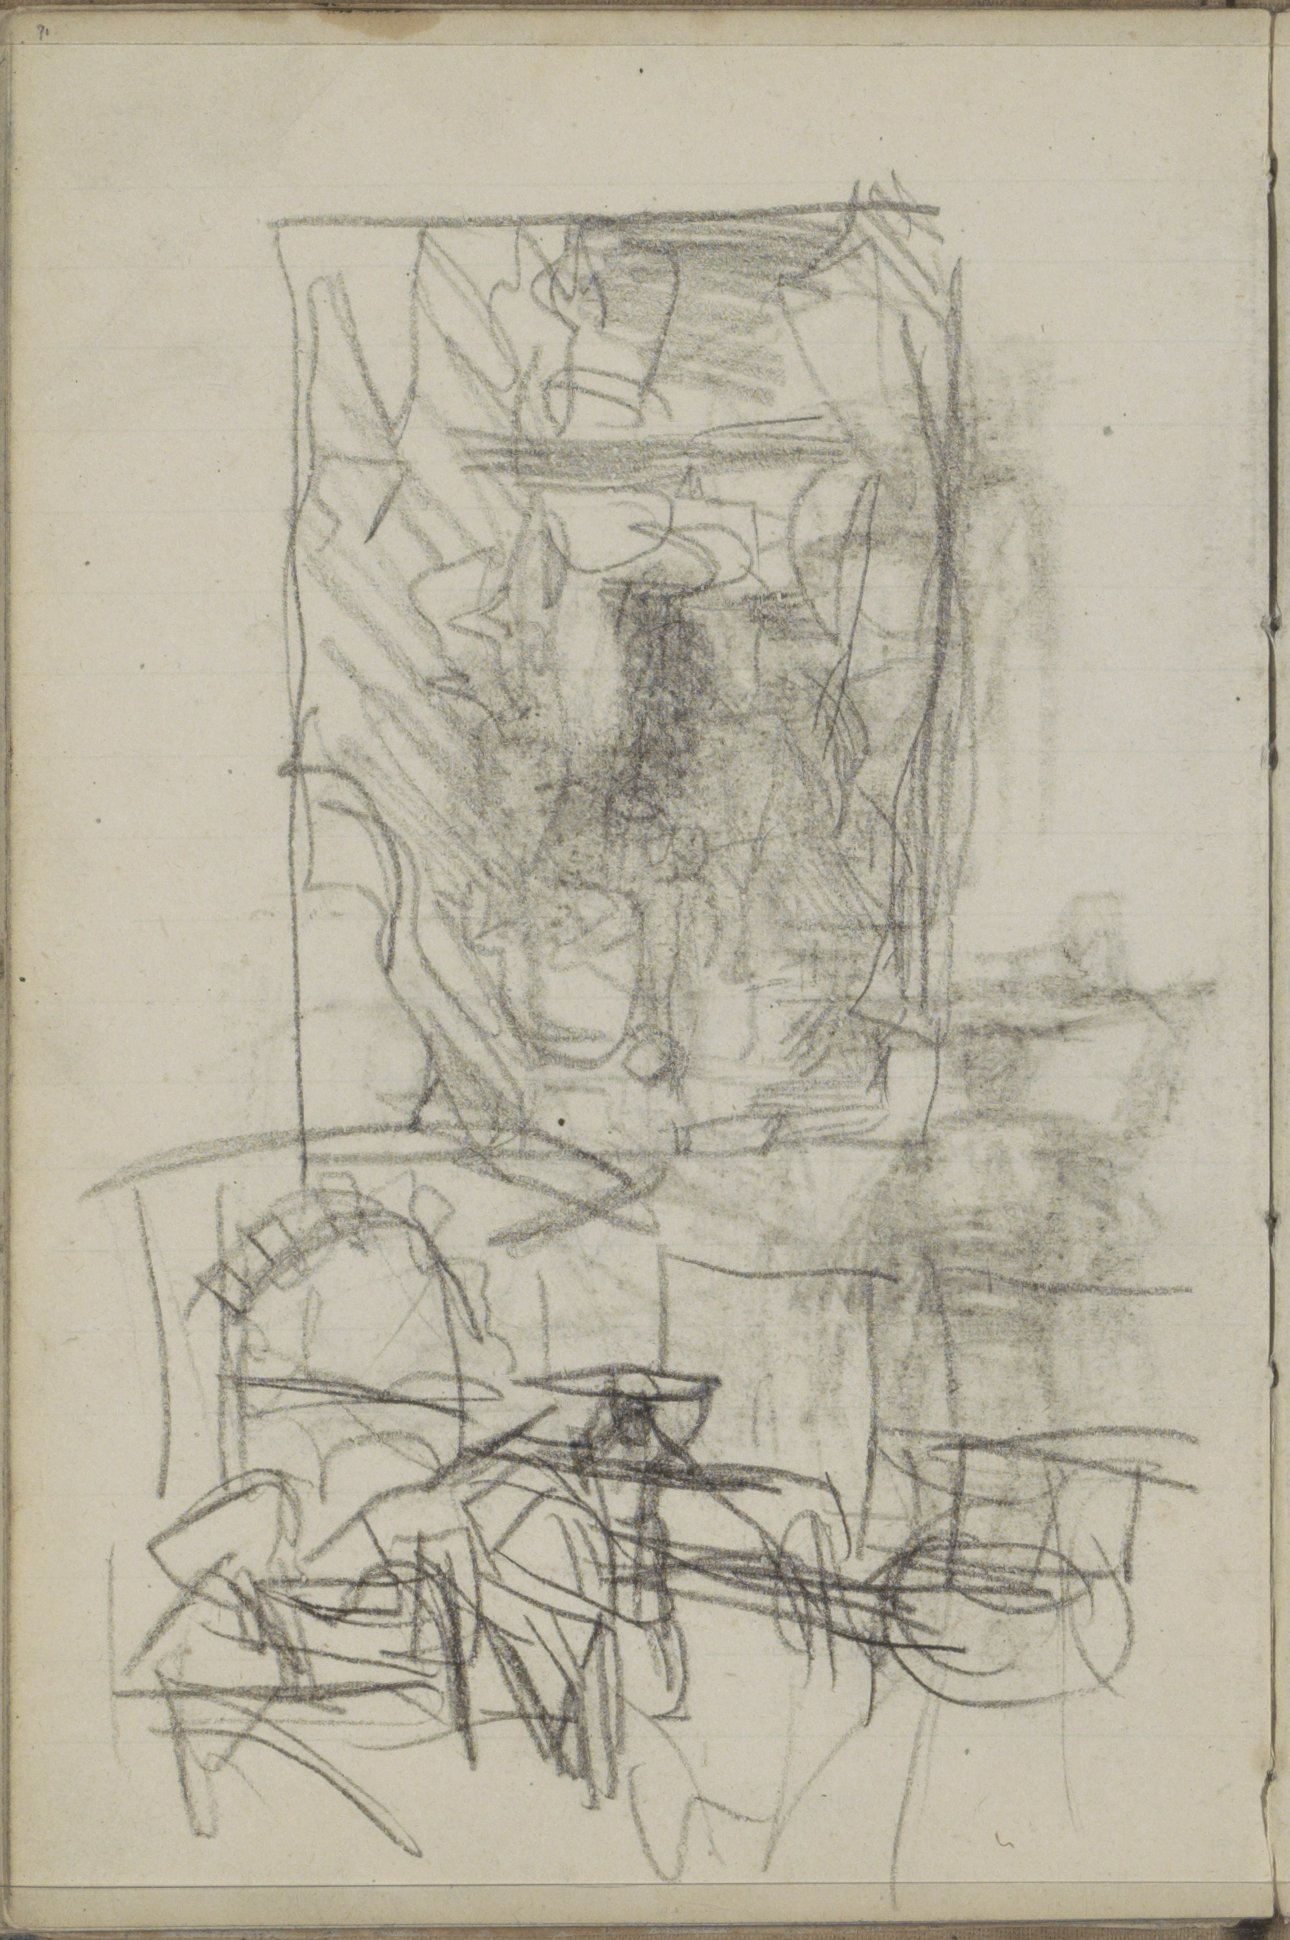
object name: sketchbook leaf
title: Studieblad, onder andere met een stenen poort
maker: marius bauer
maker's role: draughtsman, print maker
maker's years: 1867-1932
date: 1888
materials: chalk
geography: istanbul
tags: arch, archivolt ~ architecture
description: Pagina 71 uit een schetsboek met 58 bladen.